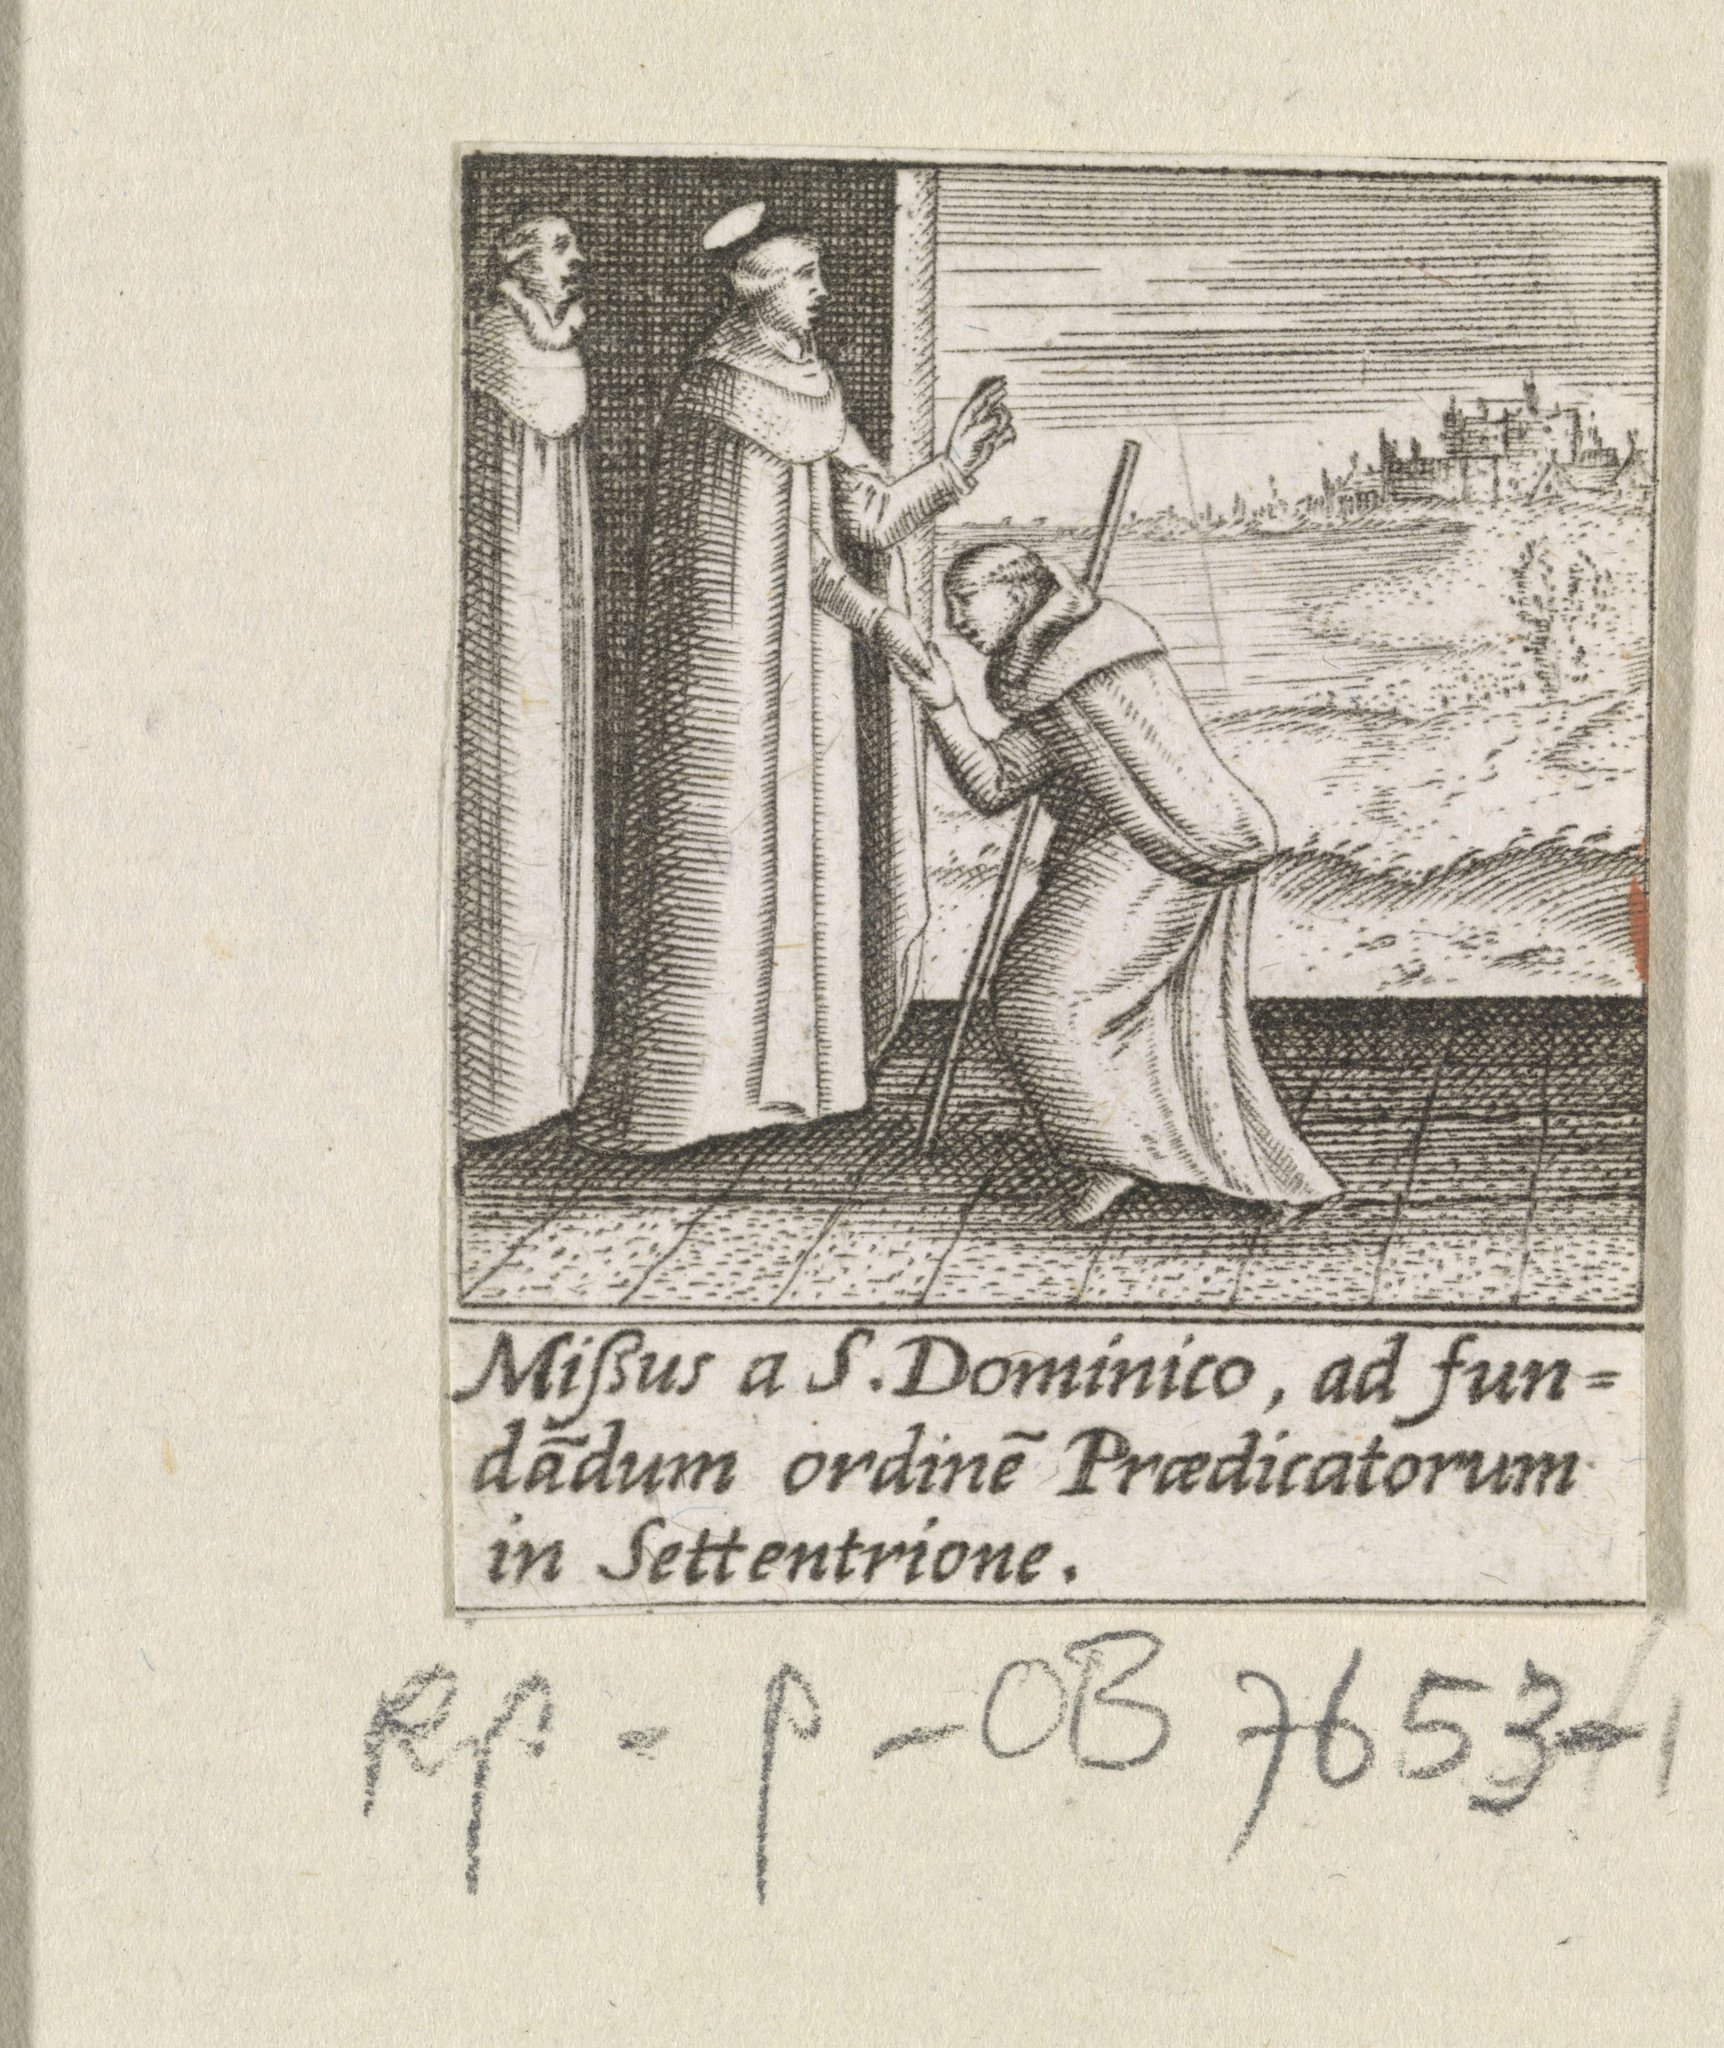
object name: print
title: Monnik begroet de Heilige Hyacinthus van Polen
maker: johann sadeler (i)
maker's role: print maker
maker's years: 1550-1600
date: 1595-1600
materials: paper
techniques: engraving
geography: venice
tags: monk(s), friar(s), the dominican friar hyacinth(us) of poland; possible attributes: book, lily, monstrance (or ciborium), statue of the virgin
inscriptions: collector's mark: Lugt 240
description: H. Hyacinthus van Polen wordt begroet door een monnik. Hij knielt en neemt de hand van de heilige vast. Op de achtergrond een stad. De prent maakt deel uit van een achttiendelige serie die een kader vormt rondom een afbeelding van de H. Hyacinthus van Polen.